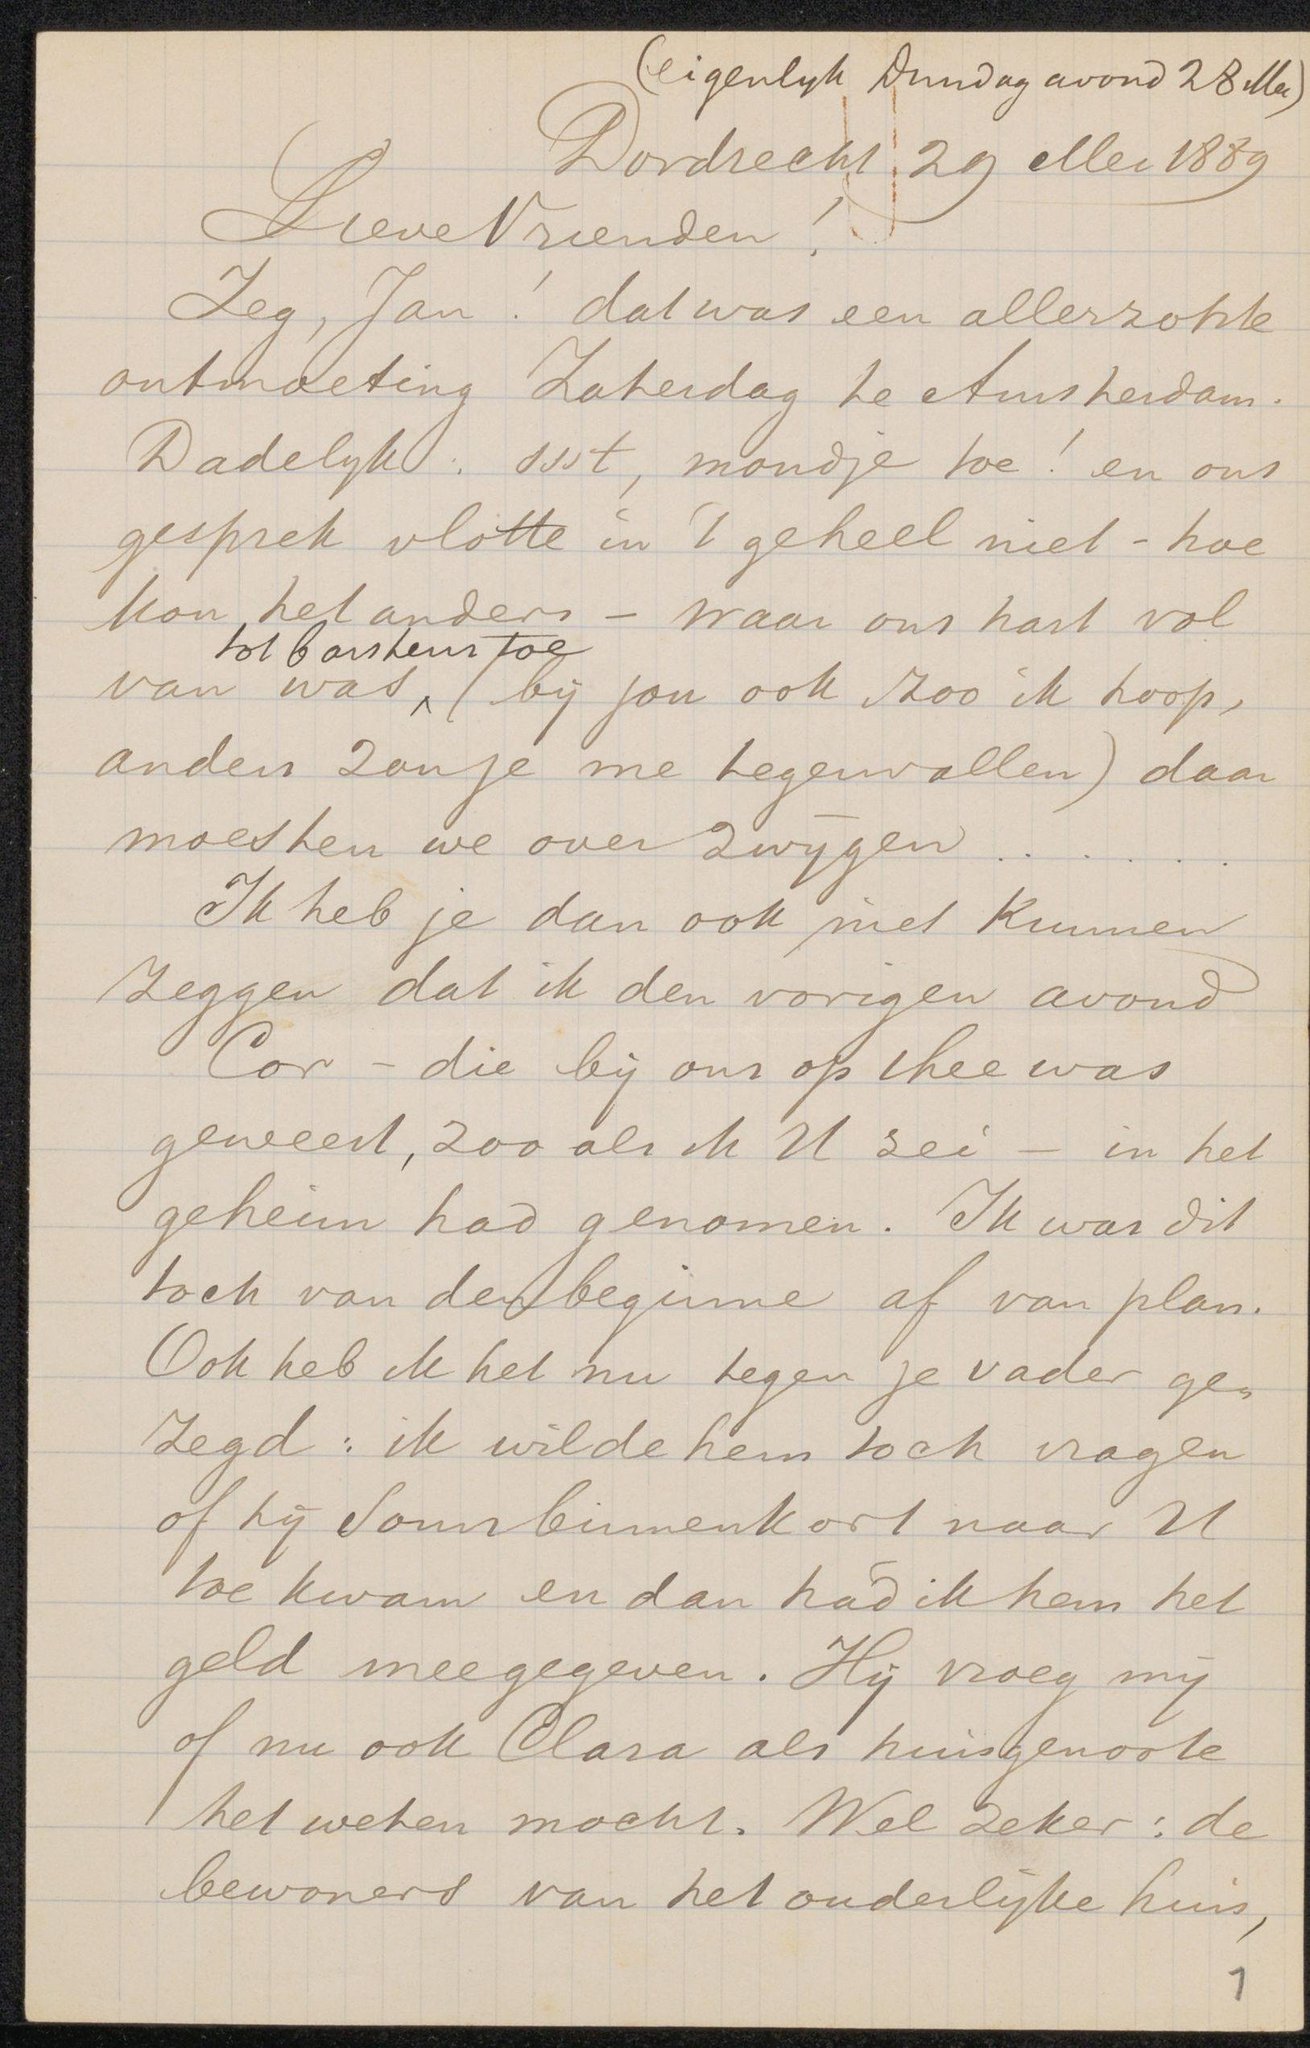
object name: letter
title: Brief aan Jan Veth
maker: martinus cornelis lebret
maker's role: verzamelaar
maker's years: 1833-1894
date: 1889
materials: ink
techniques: pen, writing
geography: dordrecht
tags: petrus johannes arendzen, haarlem, adriaen van ostade, designer, jan veth, leiden, painter, print maker, draughtsman, lucas van leyden, rembrandt van rijn, albrecht dürer, amsterdam, abraham bredius, nijmegen, the graphic arts, workshop, studio of the artist (in general), money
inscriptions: collector's mark: ‘RPK’